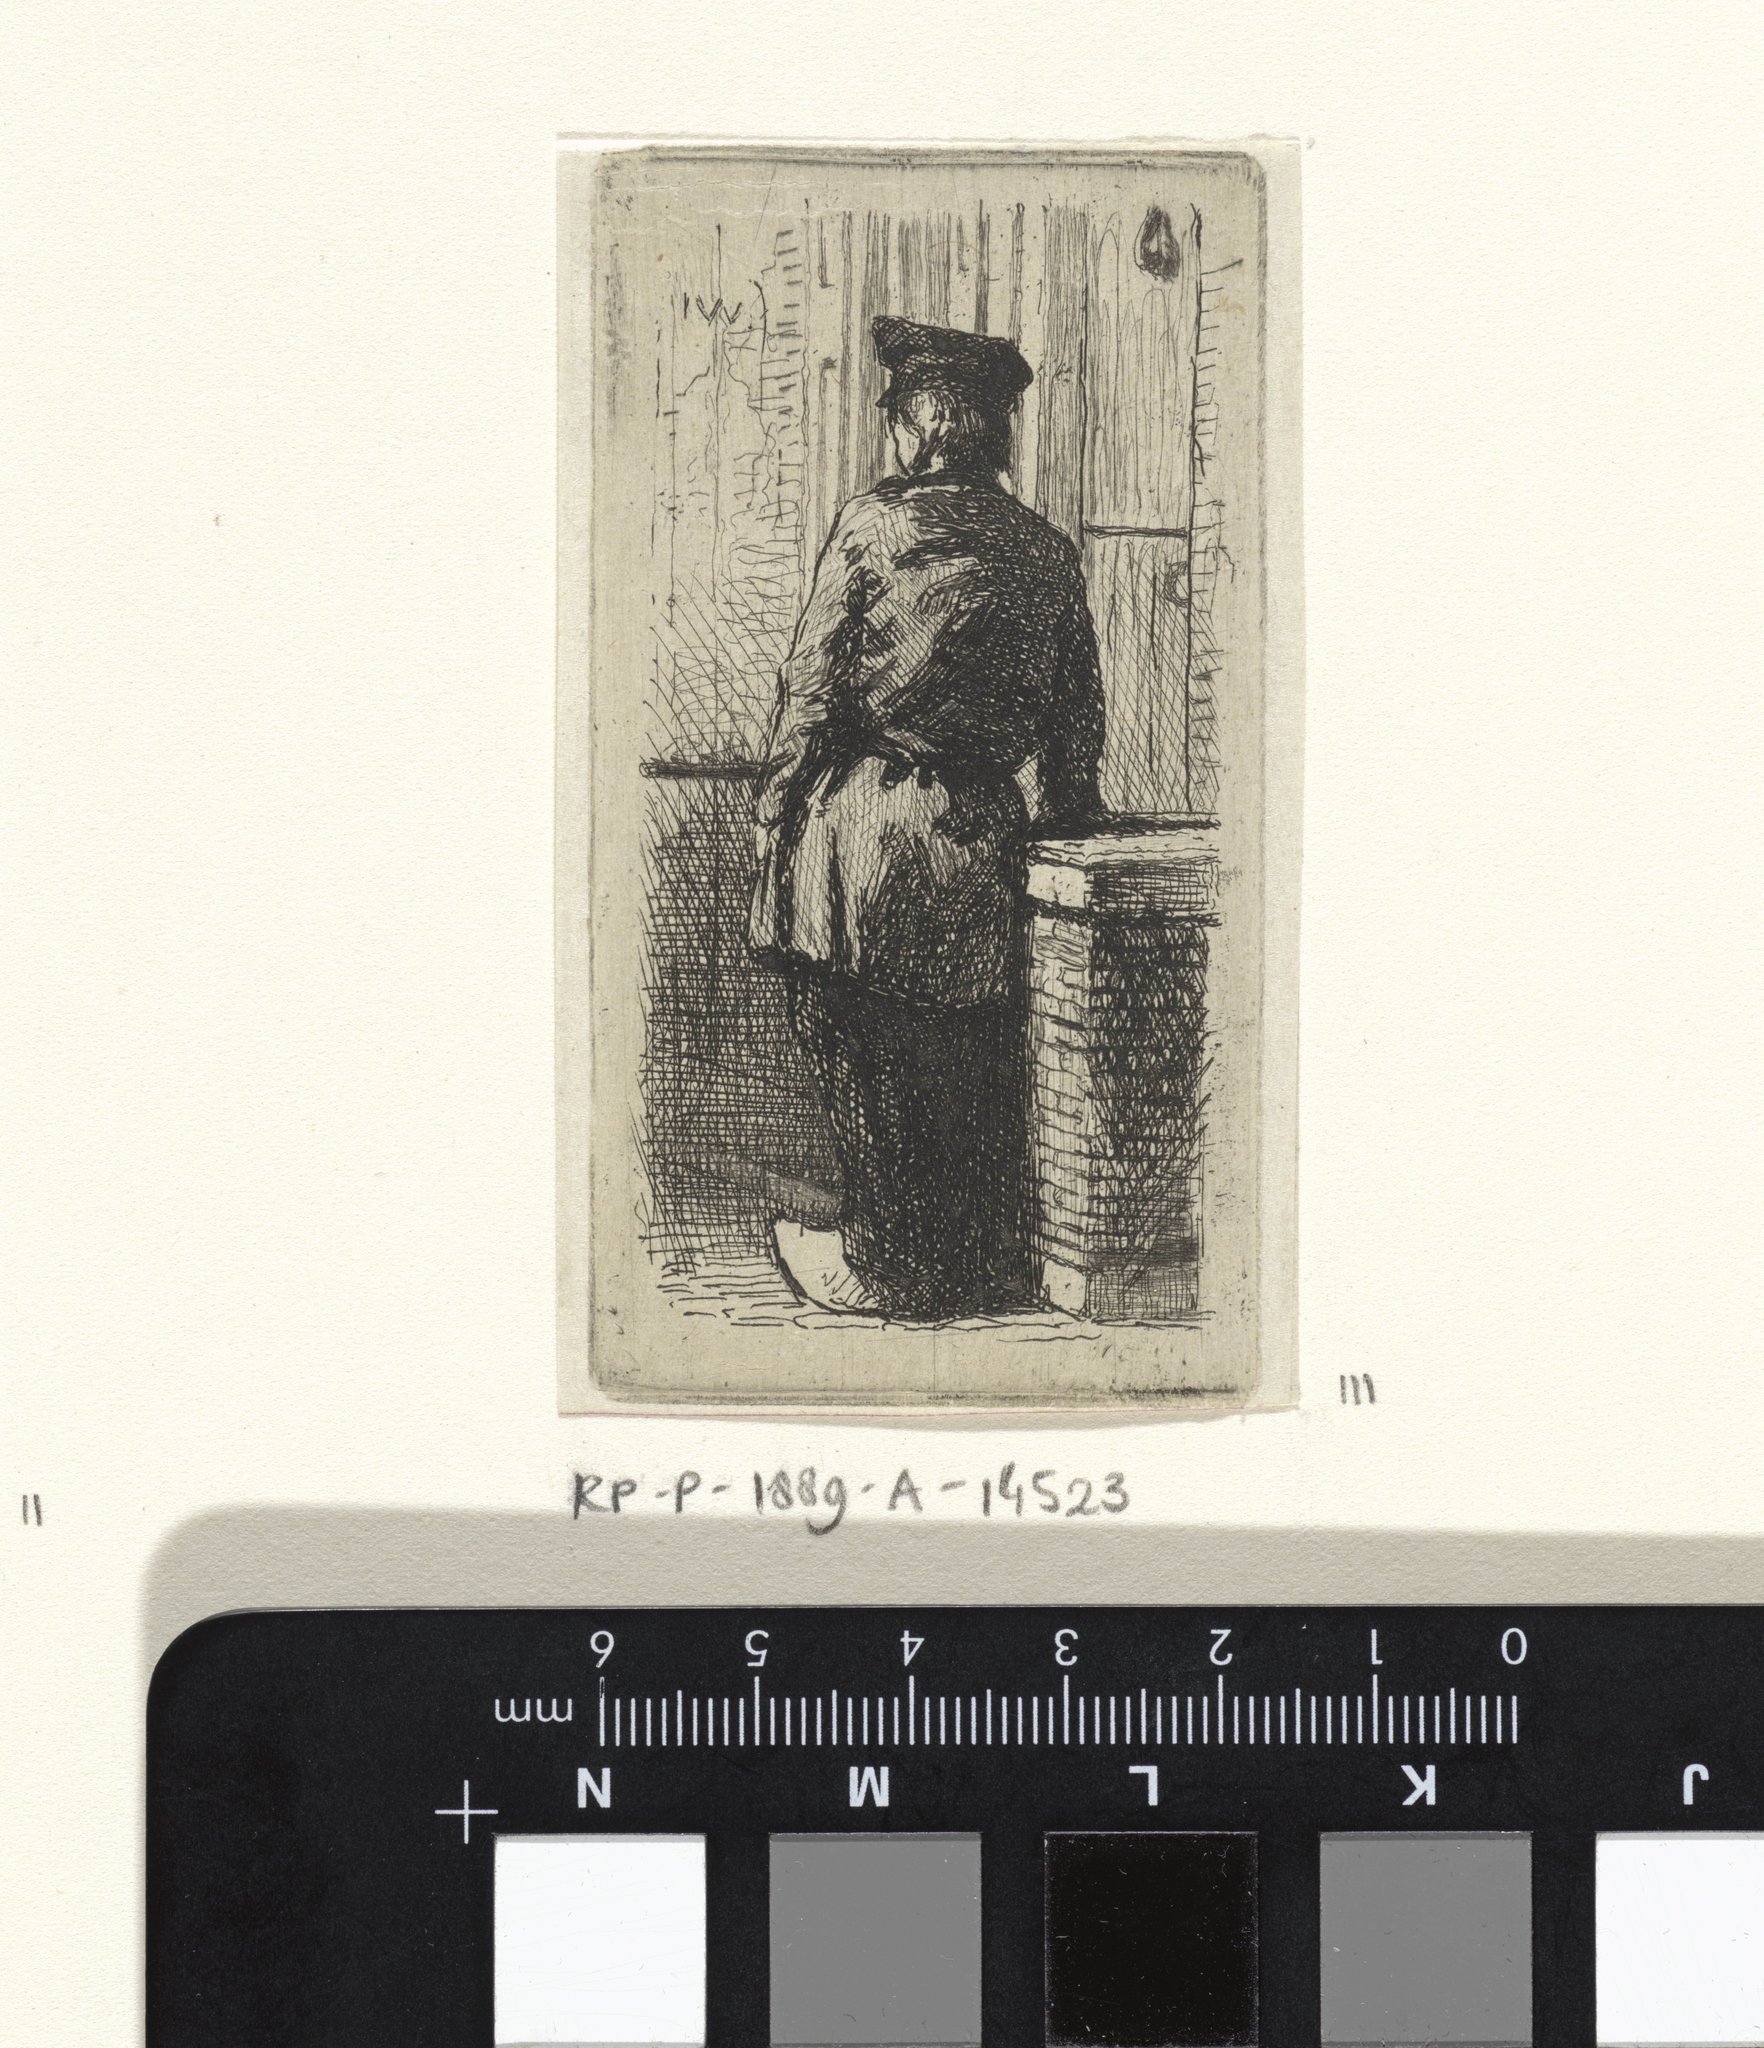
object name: print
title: Jonge man op klompen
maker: jan weissenbruch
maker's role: painter, print maker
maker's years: 1822-1880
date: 1837-1880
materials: paper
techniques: etching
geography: the hague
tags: wooden shoes, clogs, head-gear: cap (+ men's clothes), fence, wall, paling, adult man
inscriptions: collector's mark: Lugt 2228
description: Bij een schutting en een laag muurtje staat een jonge man op de rug gezien. Hij draagt klompen en een pet.